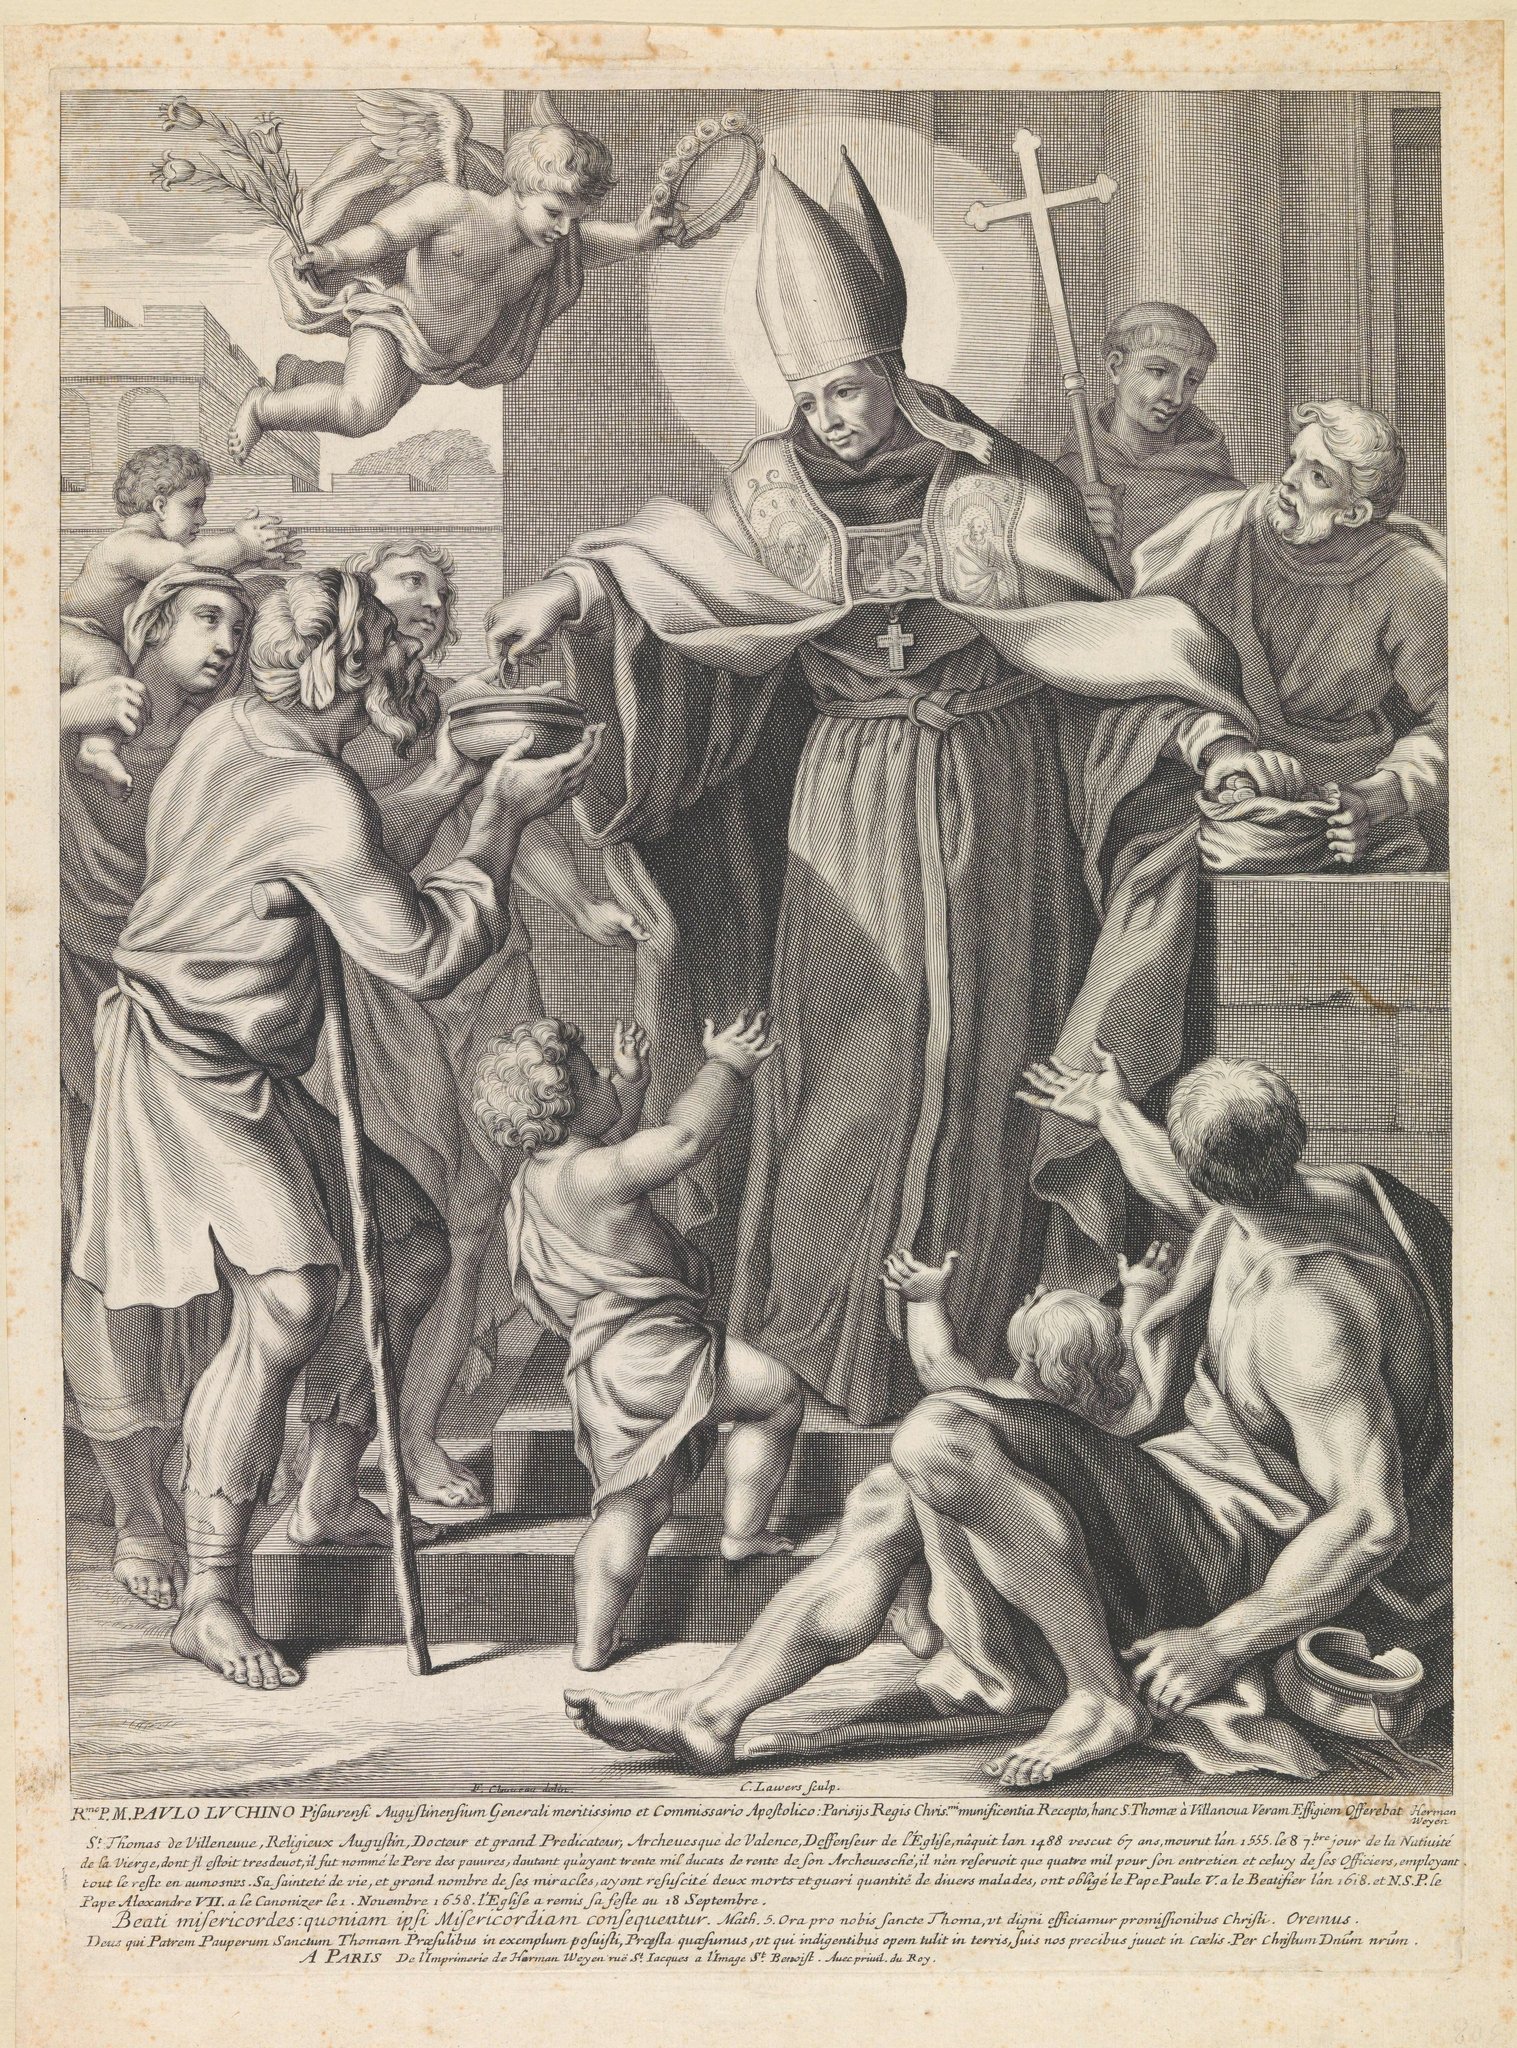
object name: print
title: H. Thomas van Villanueva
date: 1642-1685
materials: paper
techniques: engraving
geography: france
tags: giving alms or other charity, e.g.: handing out food, the augustinian friar thomas of villanueva, archbishop of valencia; possible attributes: beggars, cripples, purse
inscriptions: collector's mark: Lugt 240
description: De heilige Thomas van Villanueva, gehuld in bisschoppelijk gewaad en omgeven door een stralenkrans, is omringd door armen en zieken die hij geneest. Hij pakt munten uit een geldbuidel en deelt deze uit. Rechts kijken twee geestelijken toe, in de lucht vliegt een engel met een kroon en lelies. In de marge een onderschrift in Latijn.